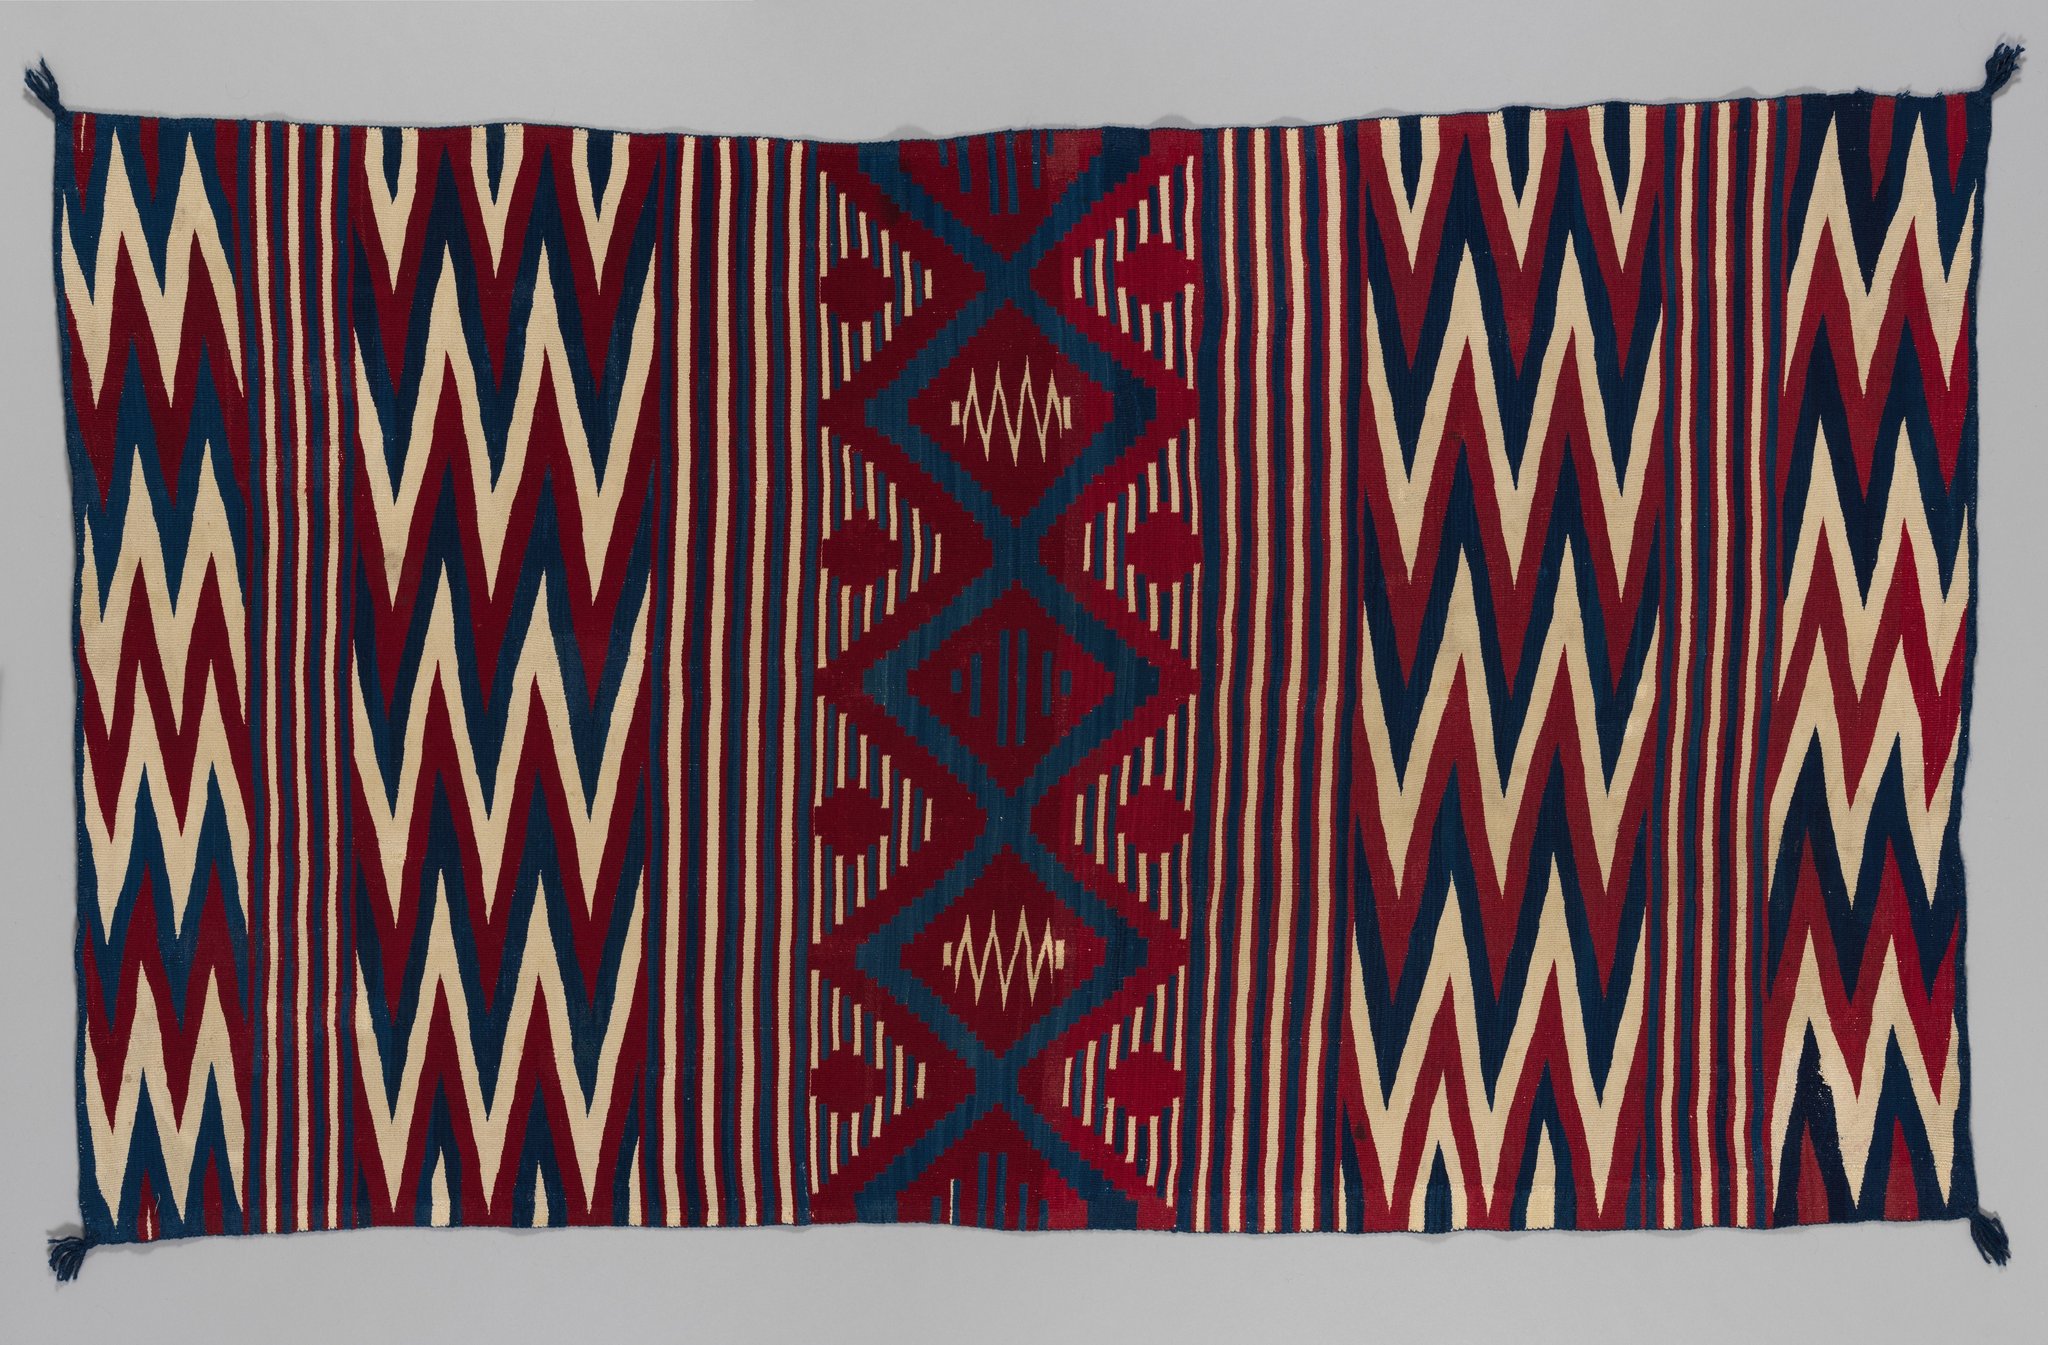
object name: serape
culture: diné or navajo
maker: unidentified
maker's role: artist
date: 1865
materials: wool